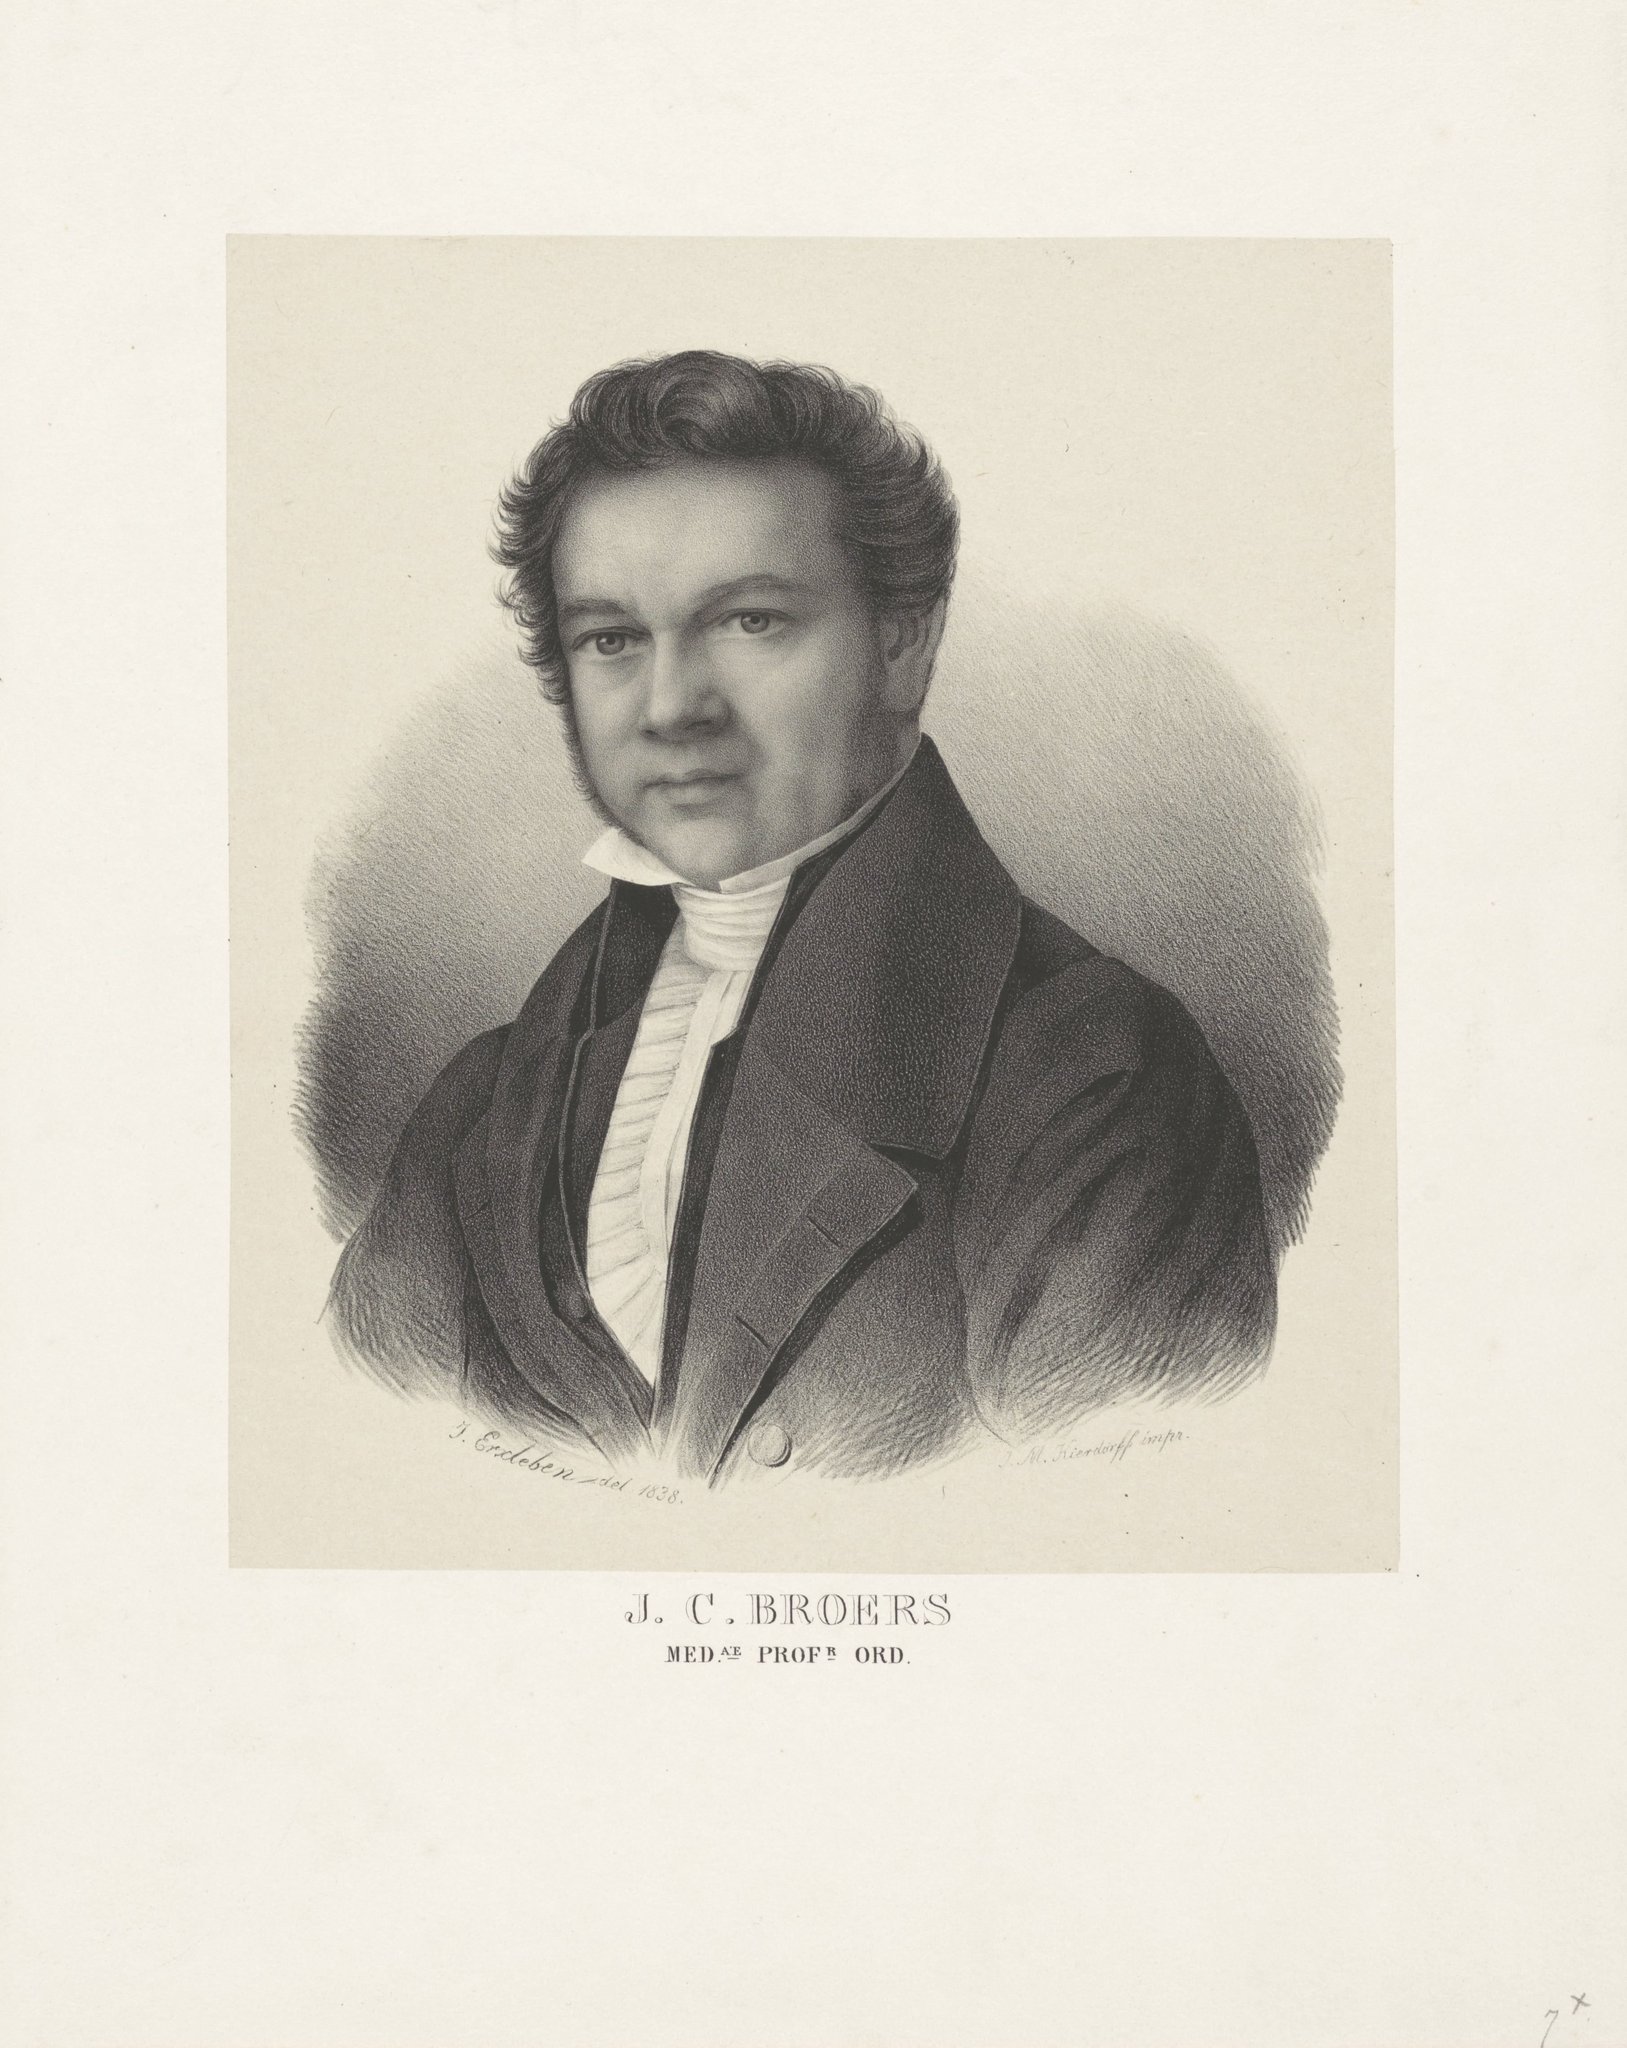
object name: print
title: Portret van Jacobus Cornelis Broers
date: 1830-1890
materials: paper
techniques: lithograph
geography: leiden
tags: leiden, historical persons (+ (full) bust portrait)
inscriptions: collector's mark: Lugt 2228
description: De geportretteerde zit naar links gewend en draagt een donkere jas over een geplooid overhemd met opstaande kraag. Onder het portret zijn naam en beroep.